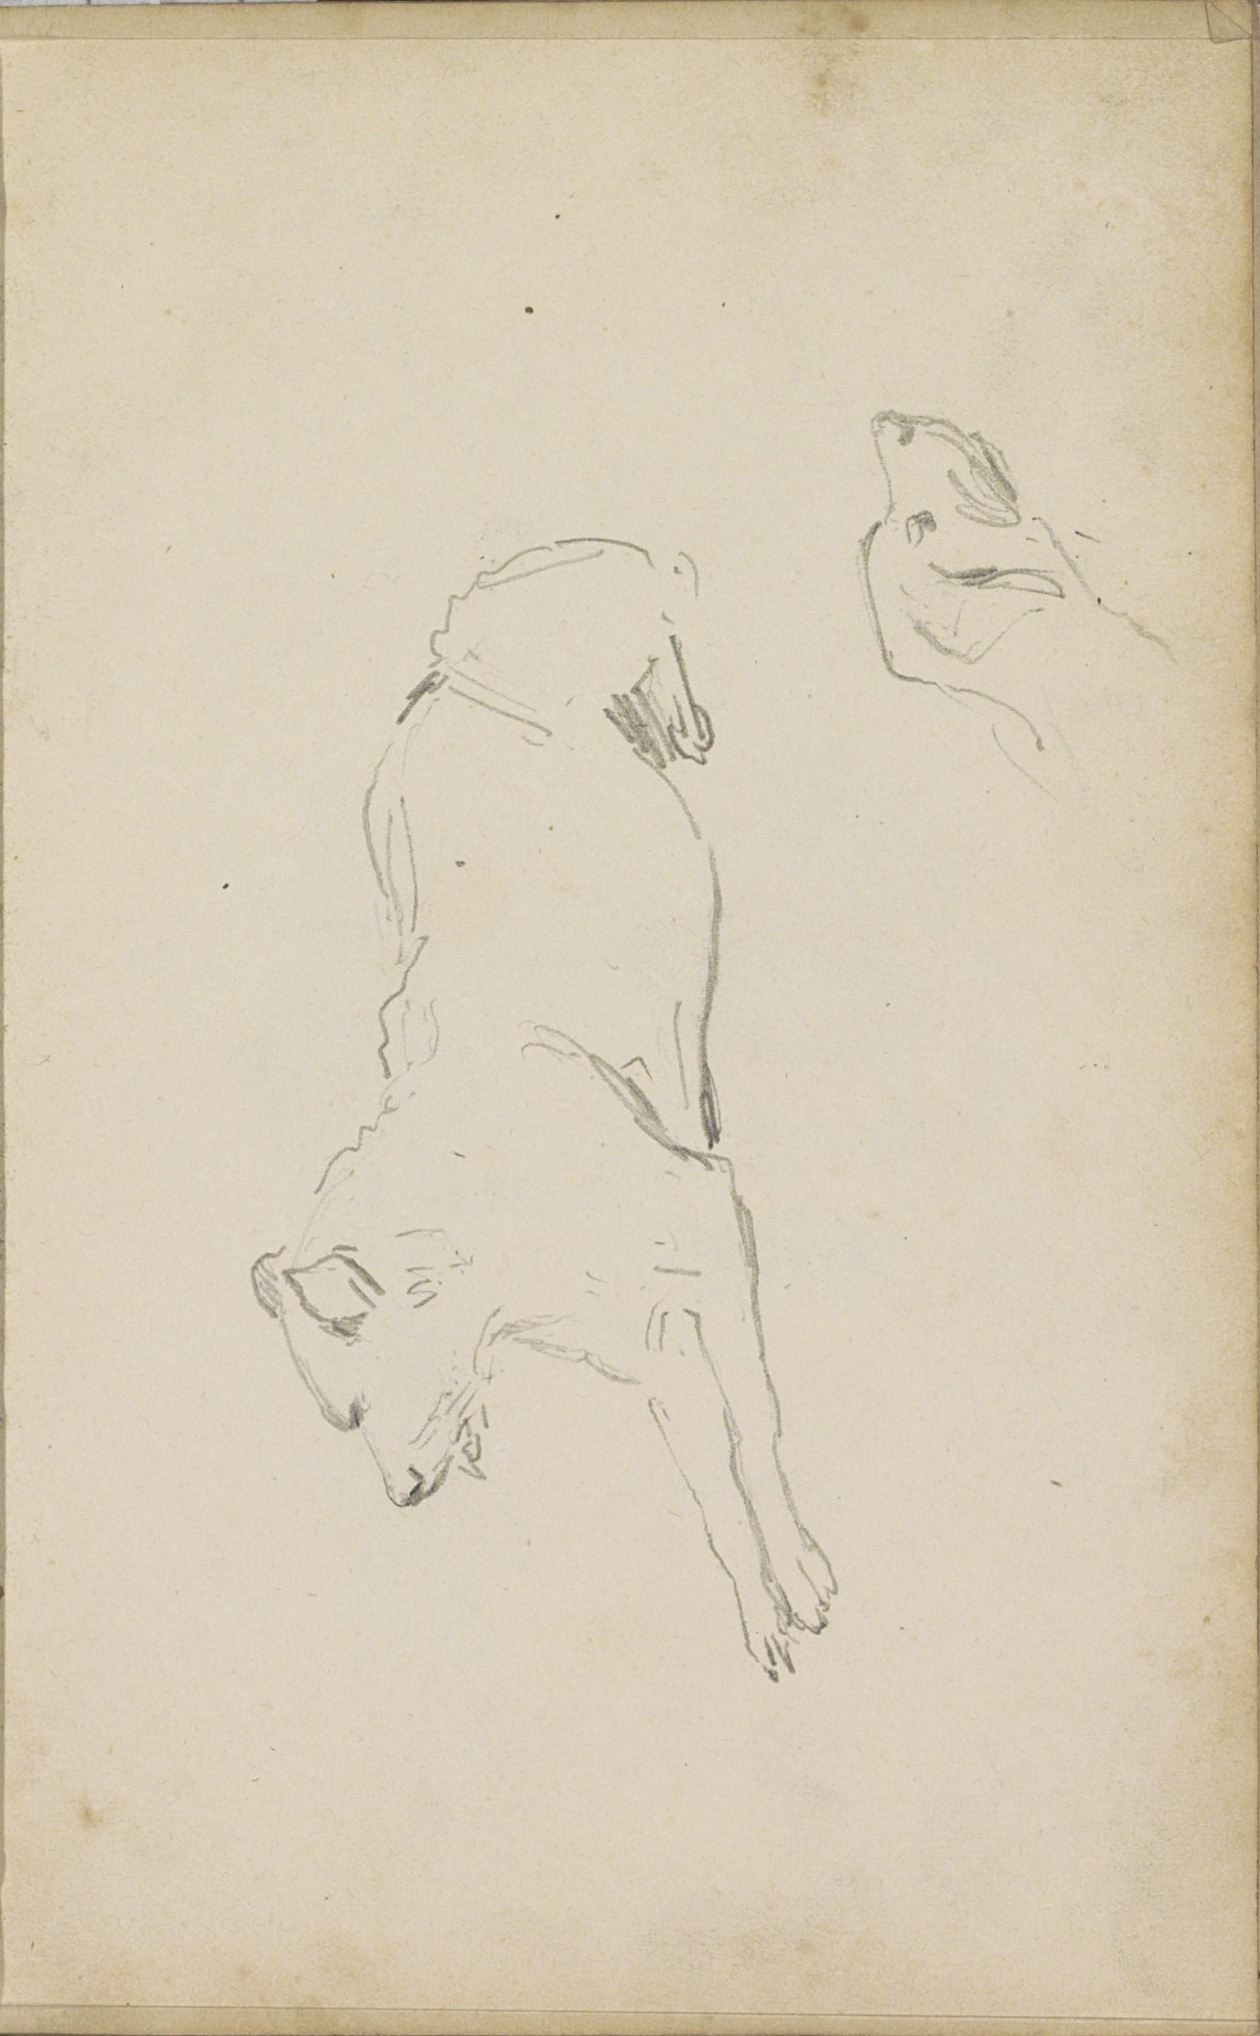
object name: sketchbook leaf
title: Liggende hond en een hondenkop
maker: johannes tavenraat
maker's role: draughtsman, painter, print maker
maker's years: 1809-1881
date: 1839-1872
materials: paper, pencil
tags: dog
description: Blad 10 recto uit een schetsboek met 73 bladen.